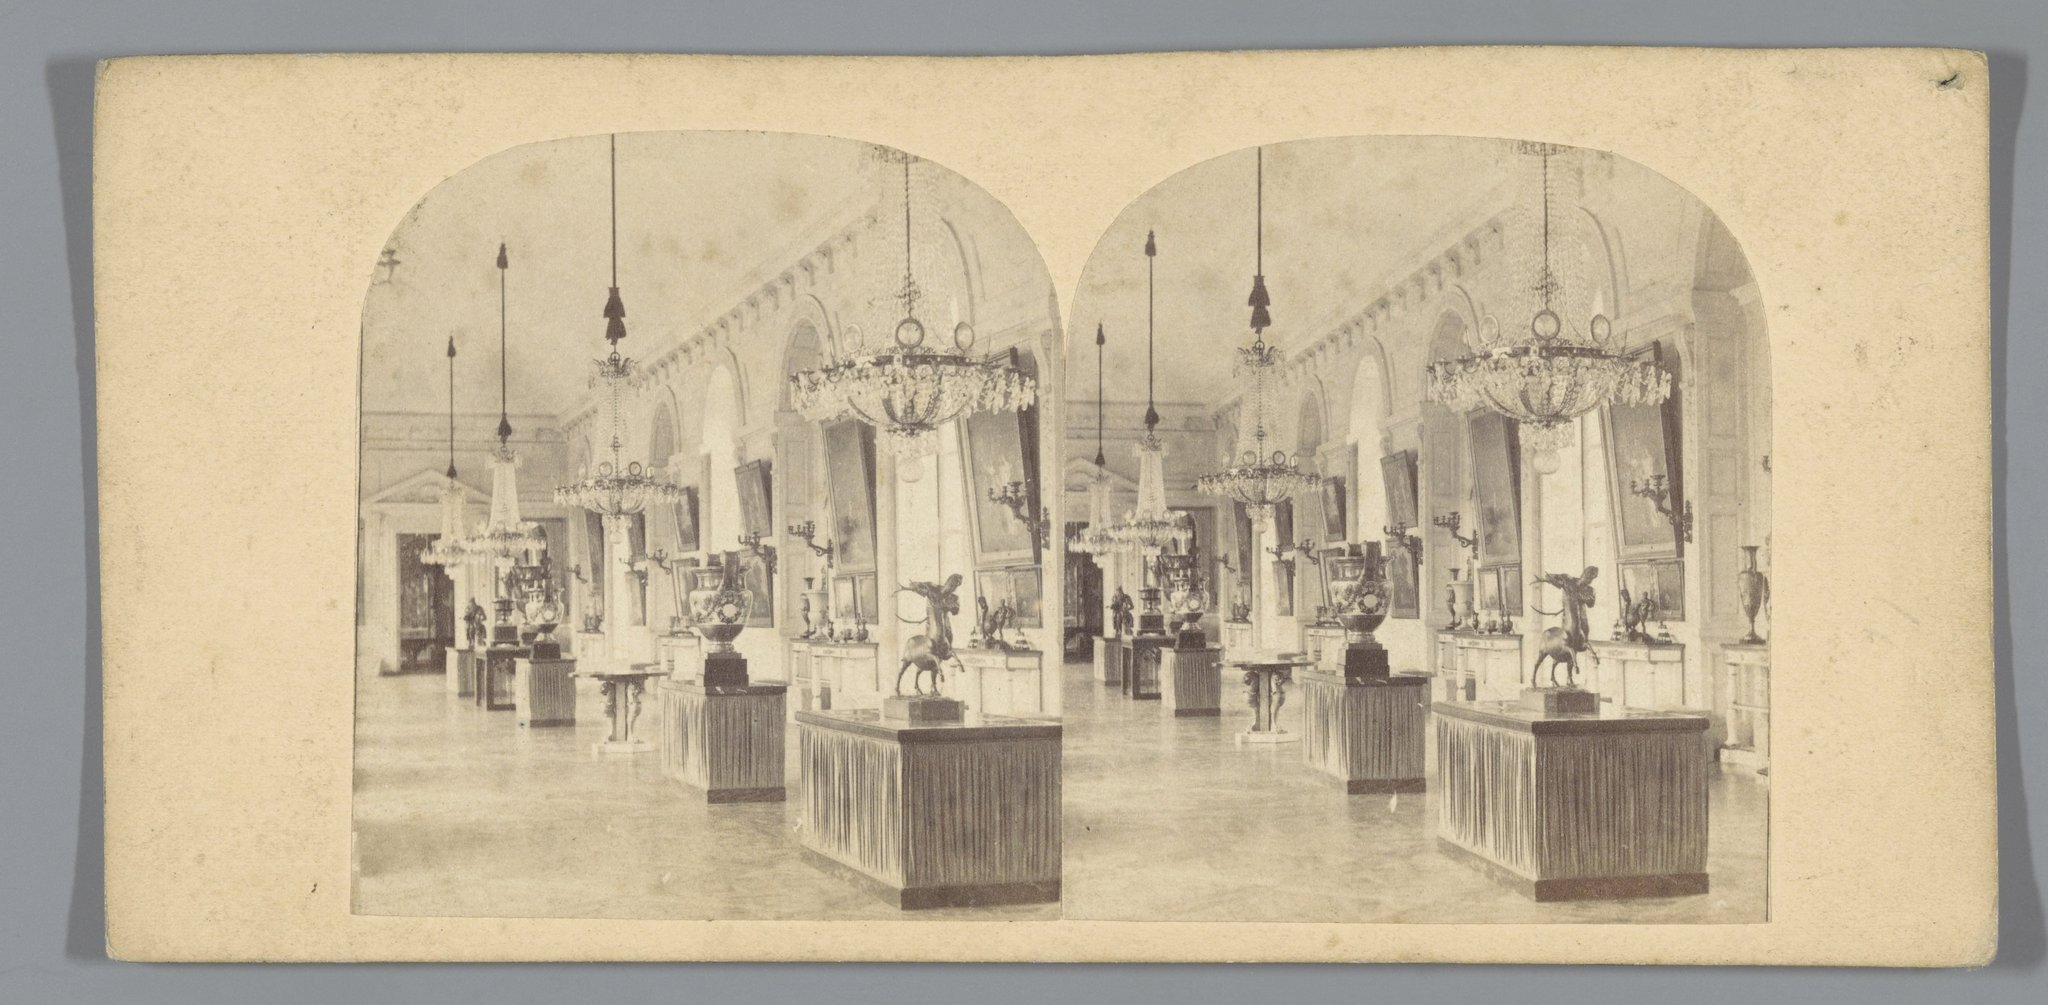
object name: stereograph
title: Galerij met vazen, sculpturen en schilderijen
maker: Anonymous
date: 1852-1858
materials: cardboard, paper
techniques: albumen print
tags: gallery of sculptures